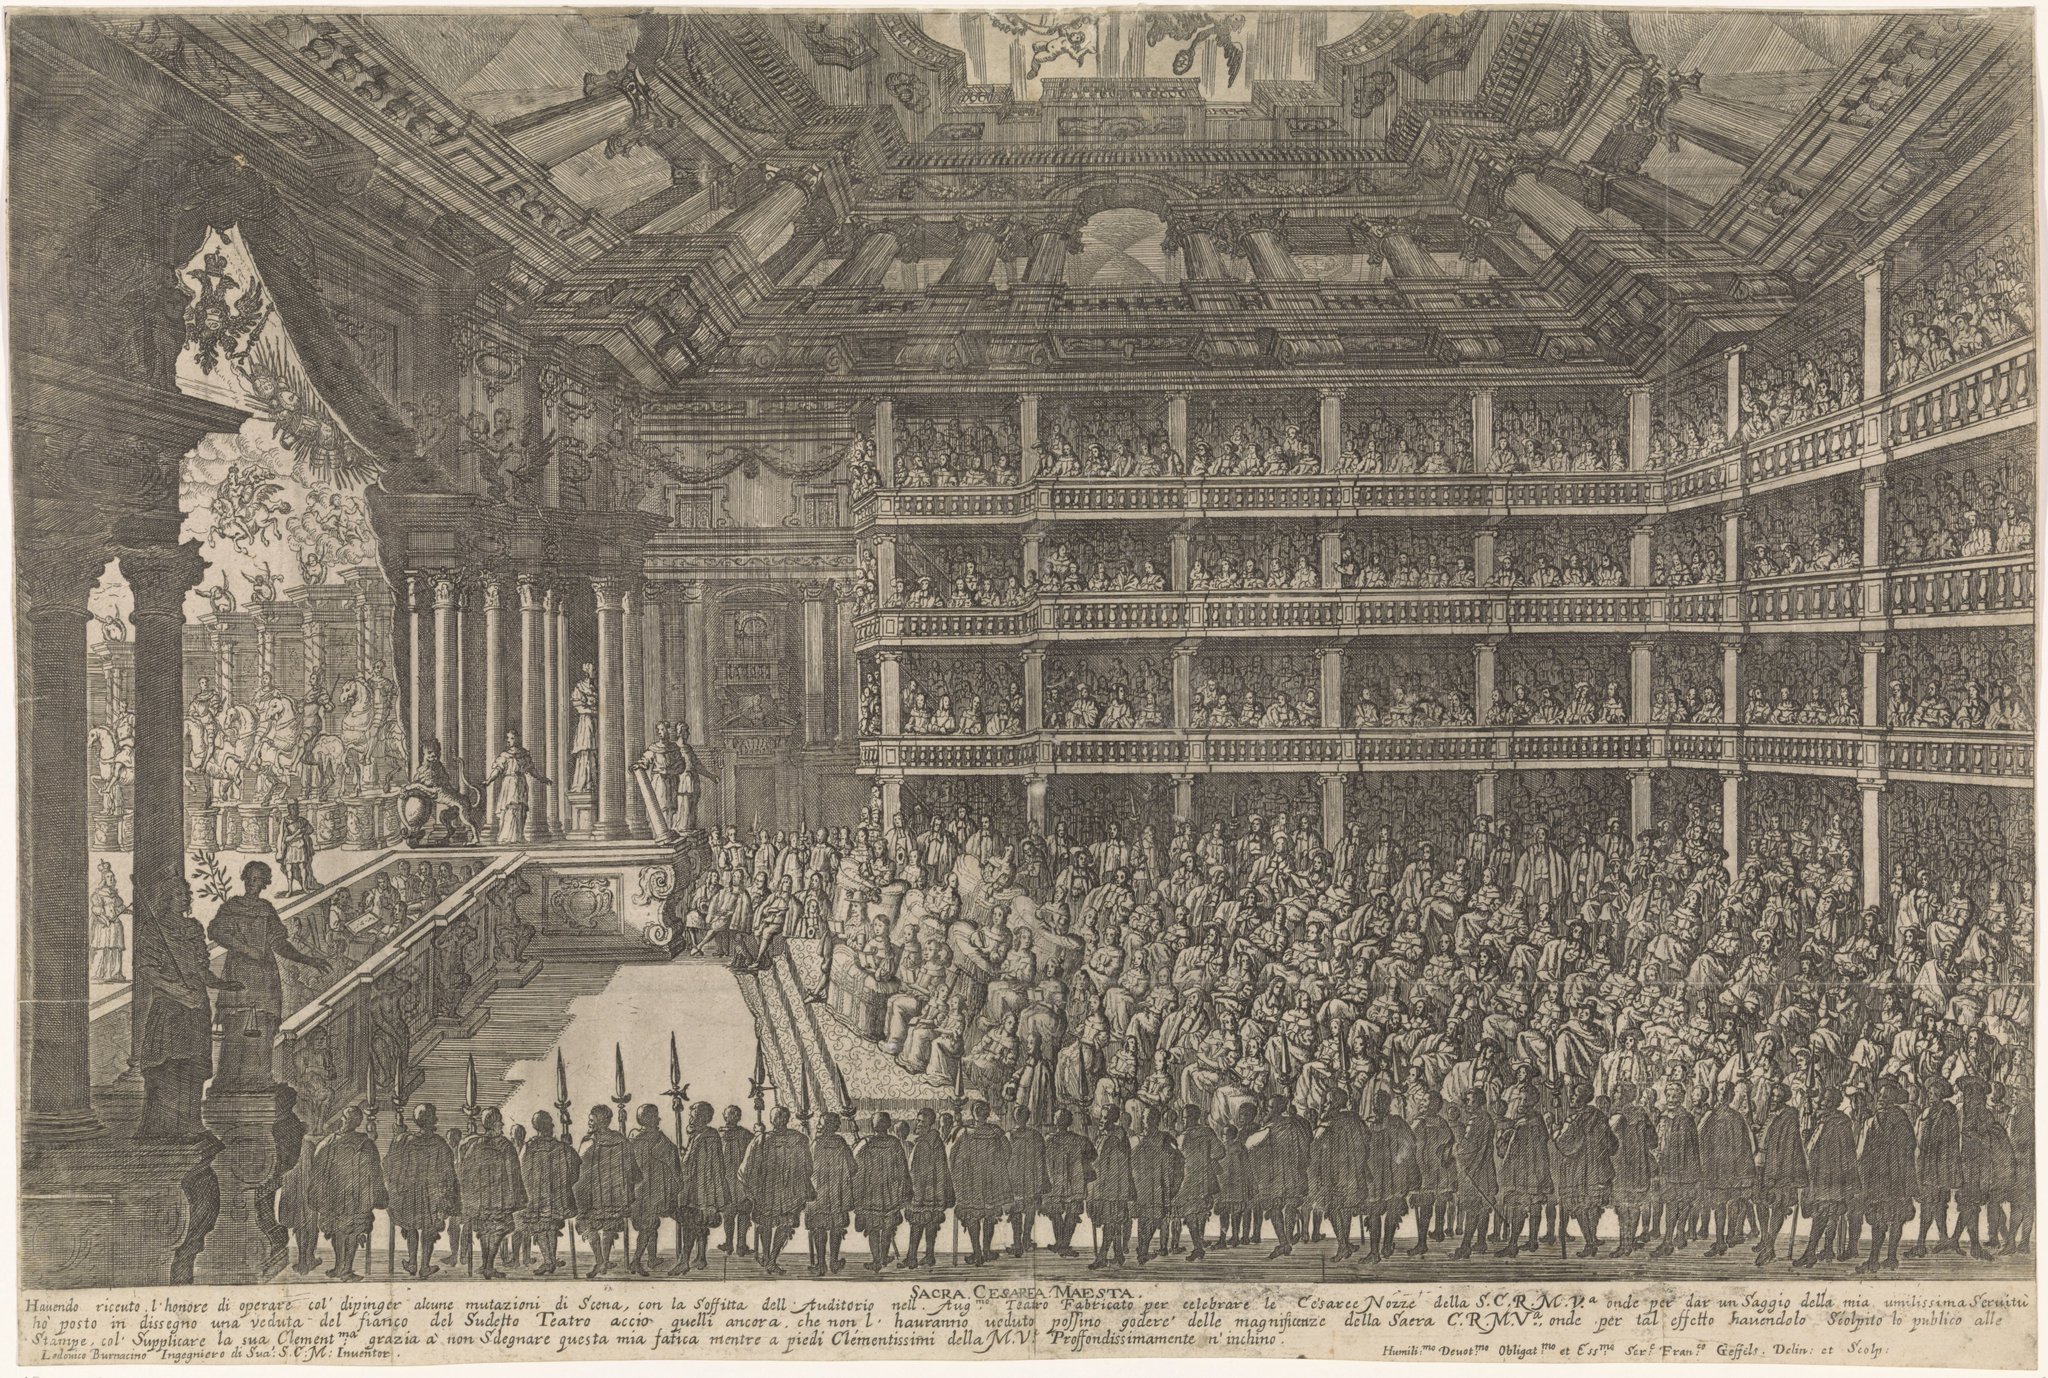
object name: print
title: Sacra cesarea Maesta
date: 1668-1670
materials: paper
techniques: etching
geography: mantua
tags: vienna, leopold i (keizer van duitsland), opera, opera house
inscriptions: collector's mark: Lugt 2166, inscription: ‘Inners des Operazaale bei den Vermalung des Kaizer Leopold I’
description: In het concertgebouw van Wenen wordt de opera 'Il Pomo d'Oro' opgevoerd voor het hof van Leopold I in Wenen ter ere van de verjaardag van de keizerin Margaretha Theresia van Spanje (1668). De keizerlijke familie zit vooraan. Op de voorgrond een rij soldaten. De prent heeft een Italiaans onderschrift.